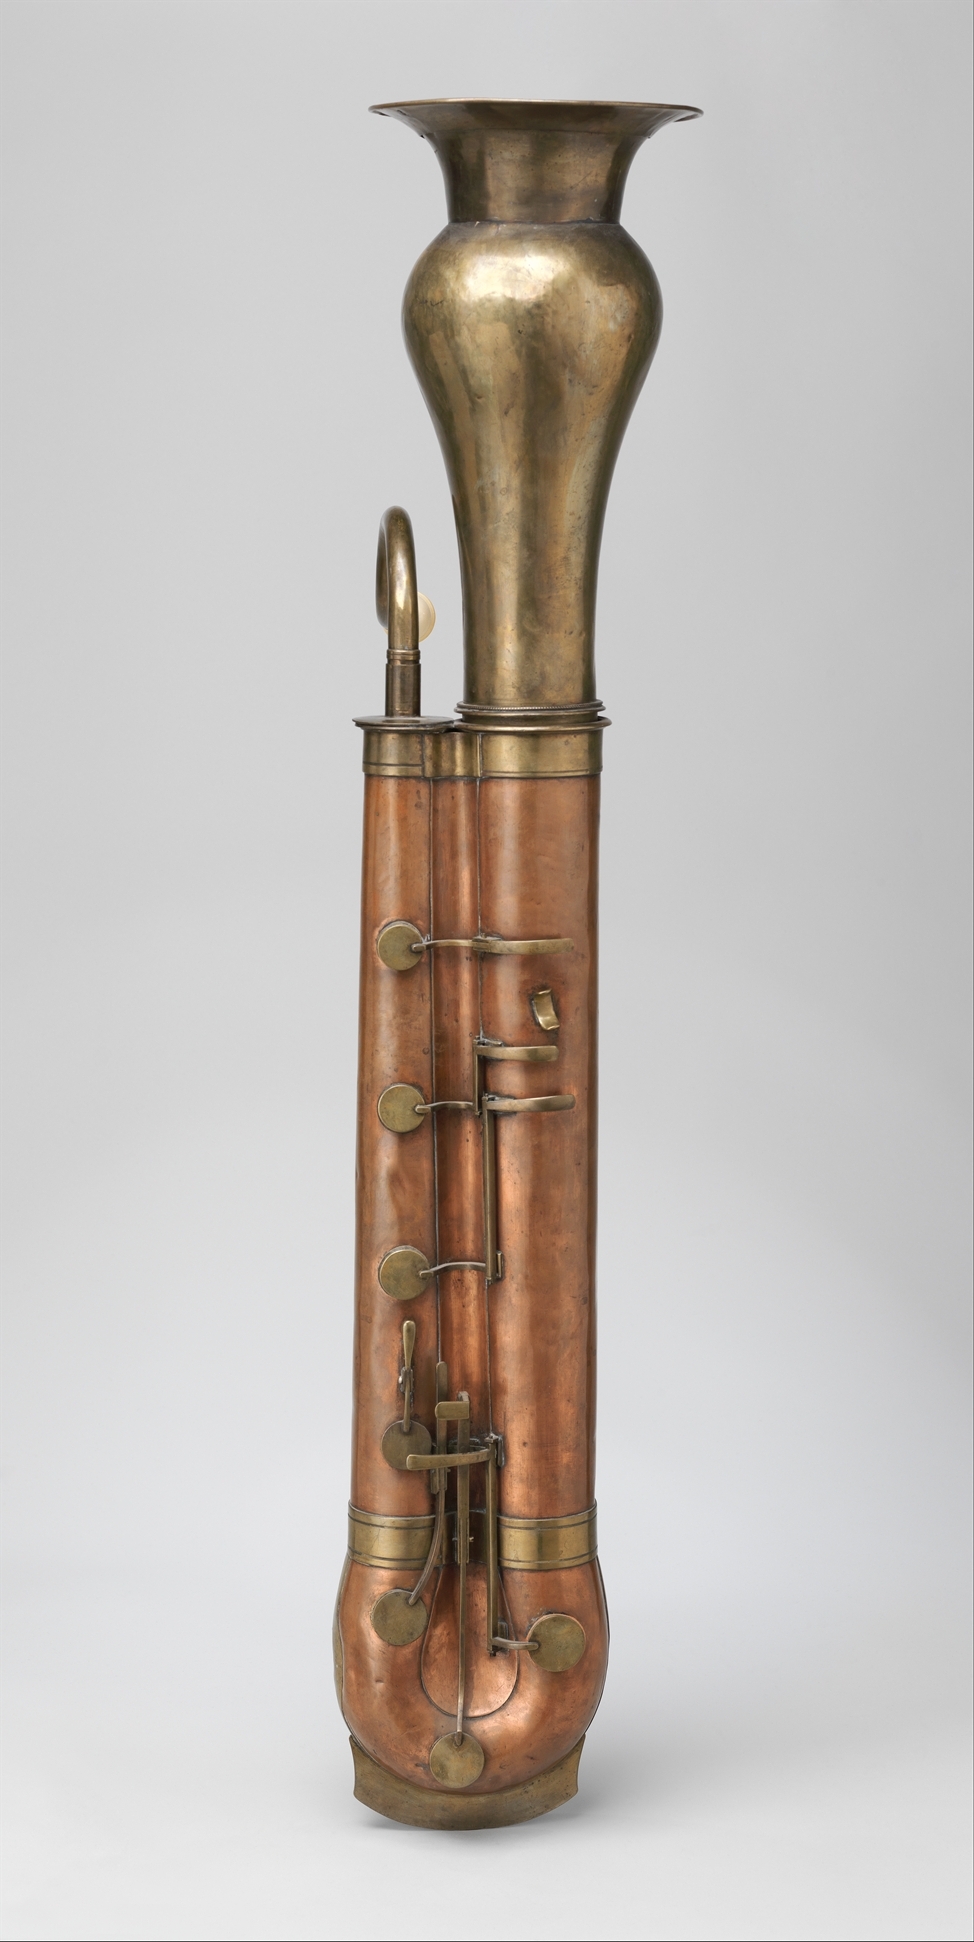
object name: chromatic bass horn in b flat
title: Chromatic Bass Horn in B-flat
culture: german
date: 1825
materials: brass, copper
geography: germany